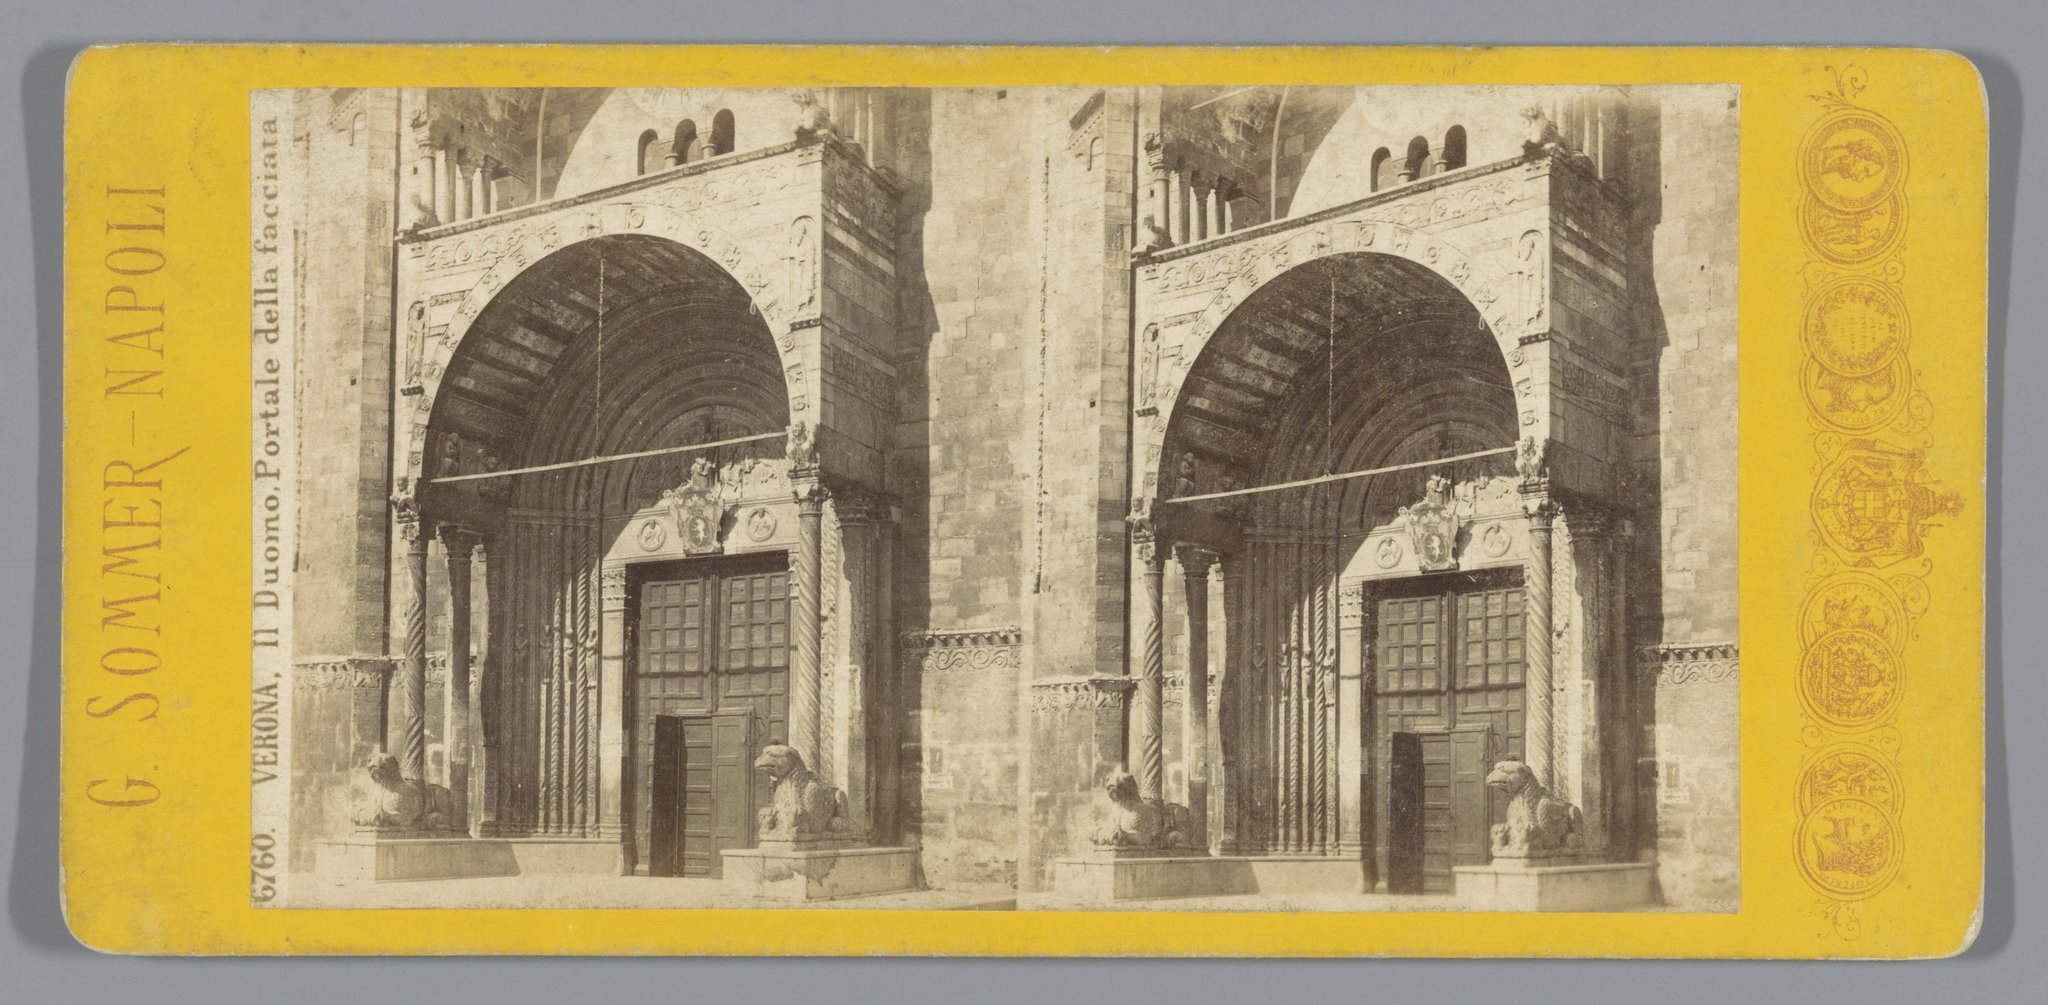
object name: stereograph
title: Gezicht op het portaal van de Dom van Verona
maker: giorgio sommer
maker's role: fotograaf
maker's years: 1834-1914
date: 1860-1880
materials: cardboard, photographic support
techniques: albumen print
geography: verona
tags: parts of church exterior and annexes: portal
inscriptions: number: ‘6760.’, inscription: ‘Verona : Dom’